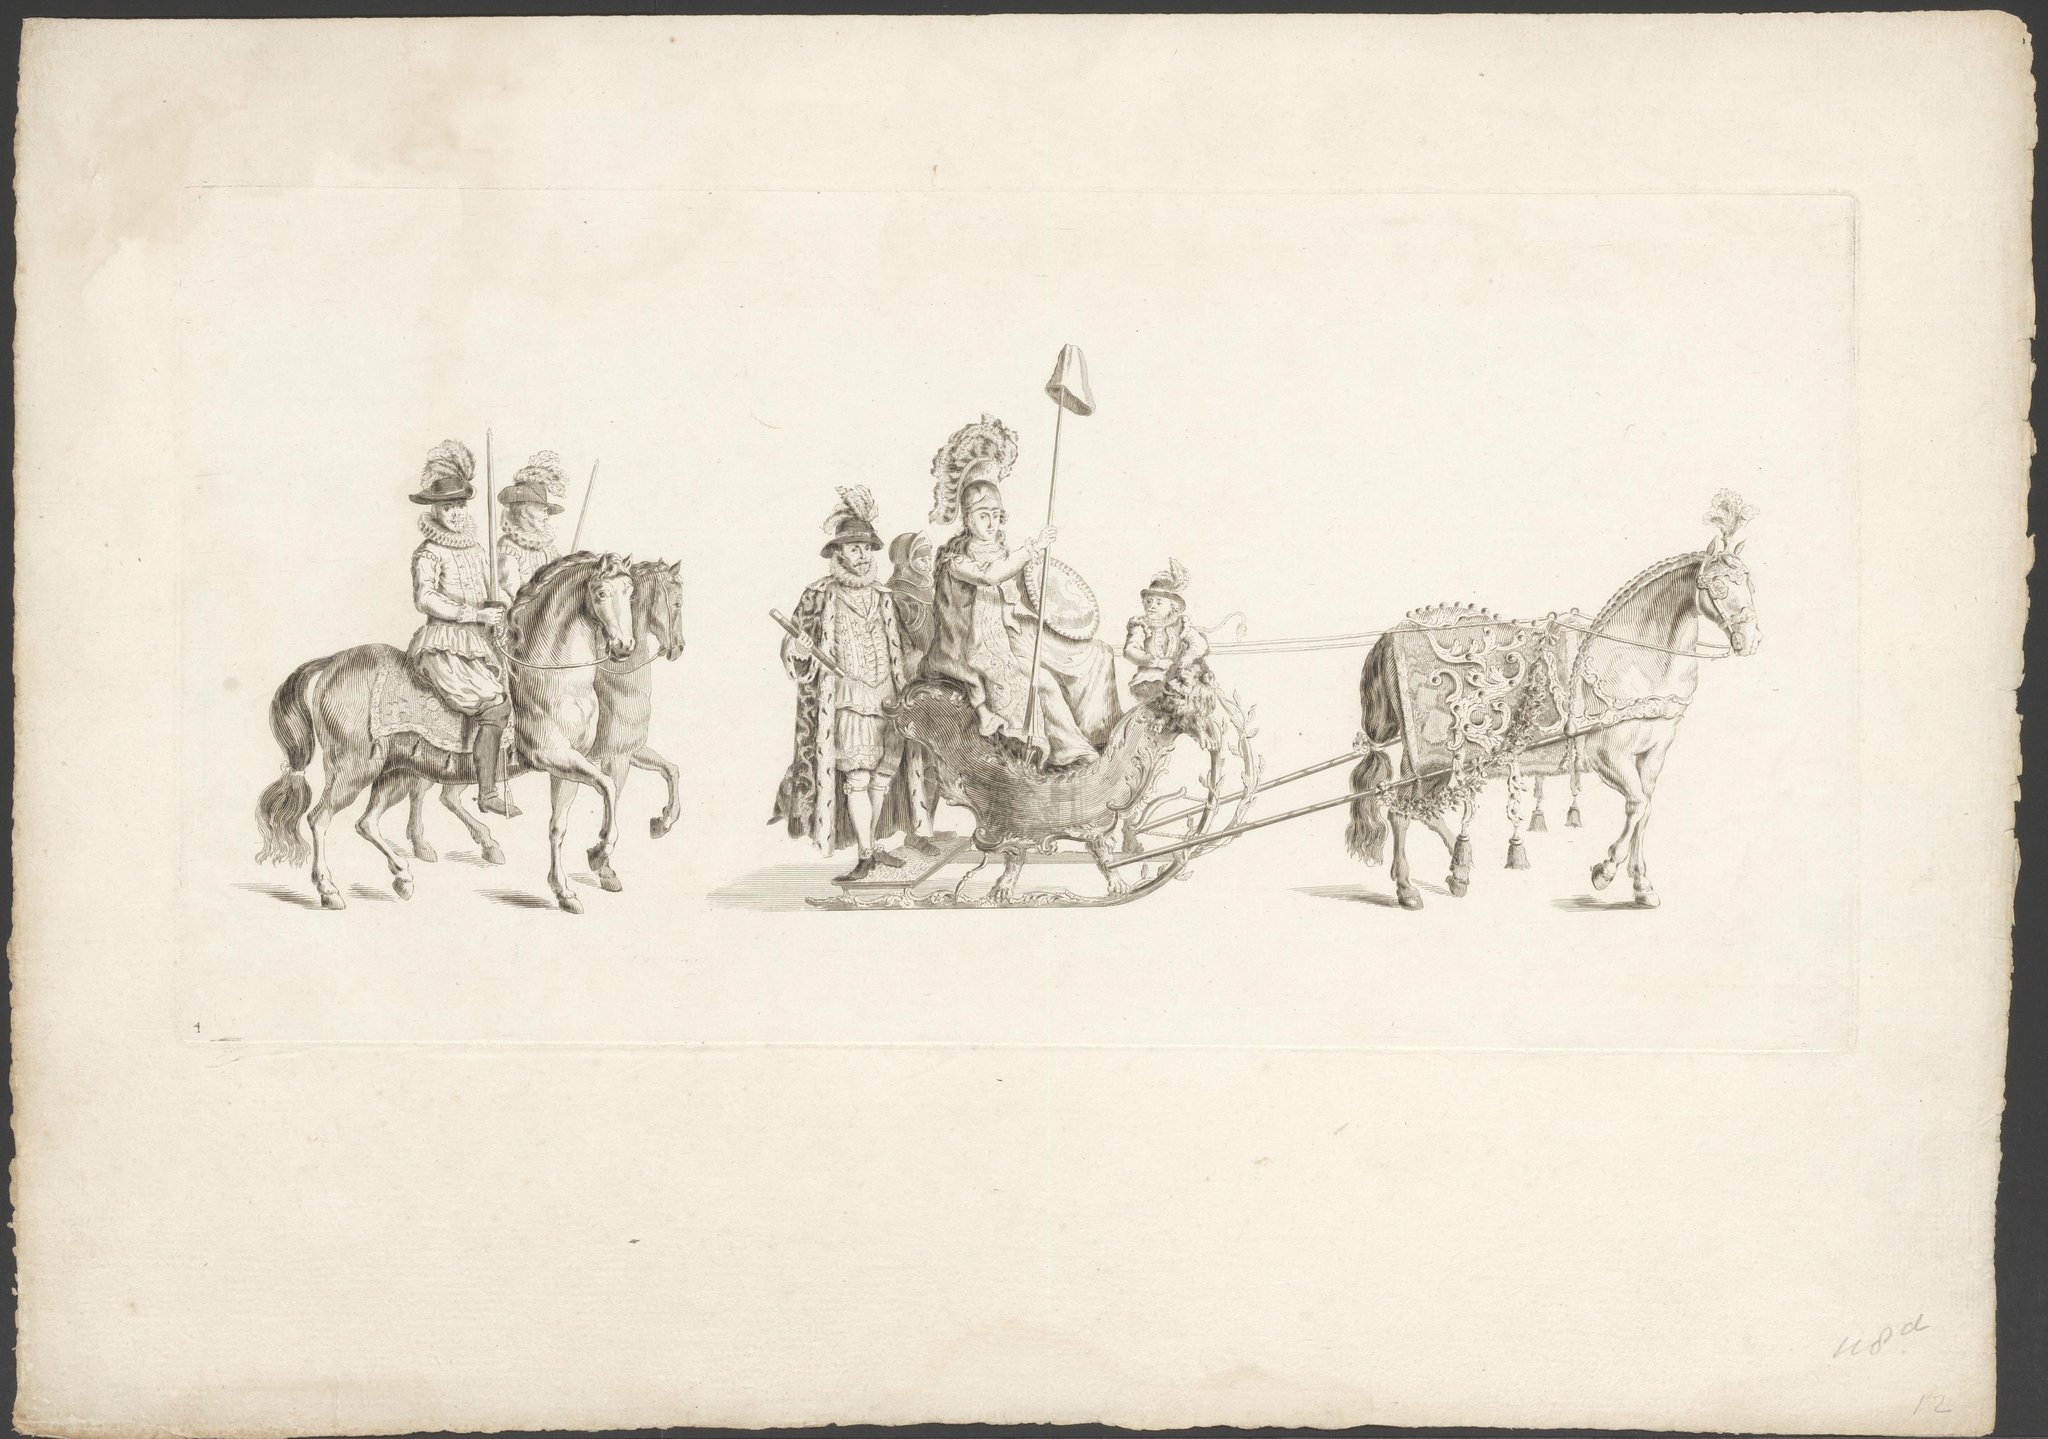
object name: print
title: Sledevaart van het Leidse genootschap Veniam Pro Laude in 1776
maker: nicolaas van der worm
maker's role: draughtsman, print maker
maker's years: 1757-1828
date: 1776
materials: paper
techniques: engraving, etching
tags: sledge, sleigh (winter sports), commemoration of the founding of a university, leiden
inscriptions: signature: ‘Dant: Hendr: Righout’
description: De vierde slede in de optocht. Een slede waarin de personificatie van de Vrijheid, met Willem van Oranje en een ridder, getrokken door een paard en gevolgd door edelen te paard. Onderdeel van een reeks van twaalf platen van de sledevaart op 24 januari 1776 georganiseerd door het Leidse genootschap Veniam Pro Laude bij gelegenheid van het Tweede Eeuwfeest van het Leids Ontzet (3 oktober 1574) en de oprichting van de Universiteit van Leiden (8 februari 1575). Linksonder genummerd: 4. Onderwerpsrubrieken binnen de Atlas Zeden en Gewoonten: Onderwijs en Wetenschappen, Studentenleven.